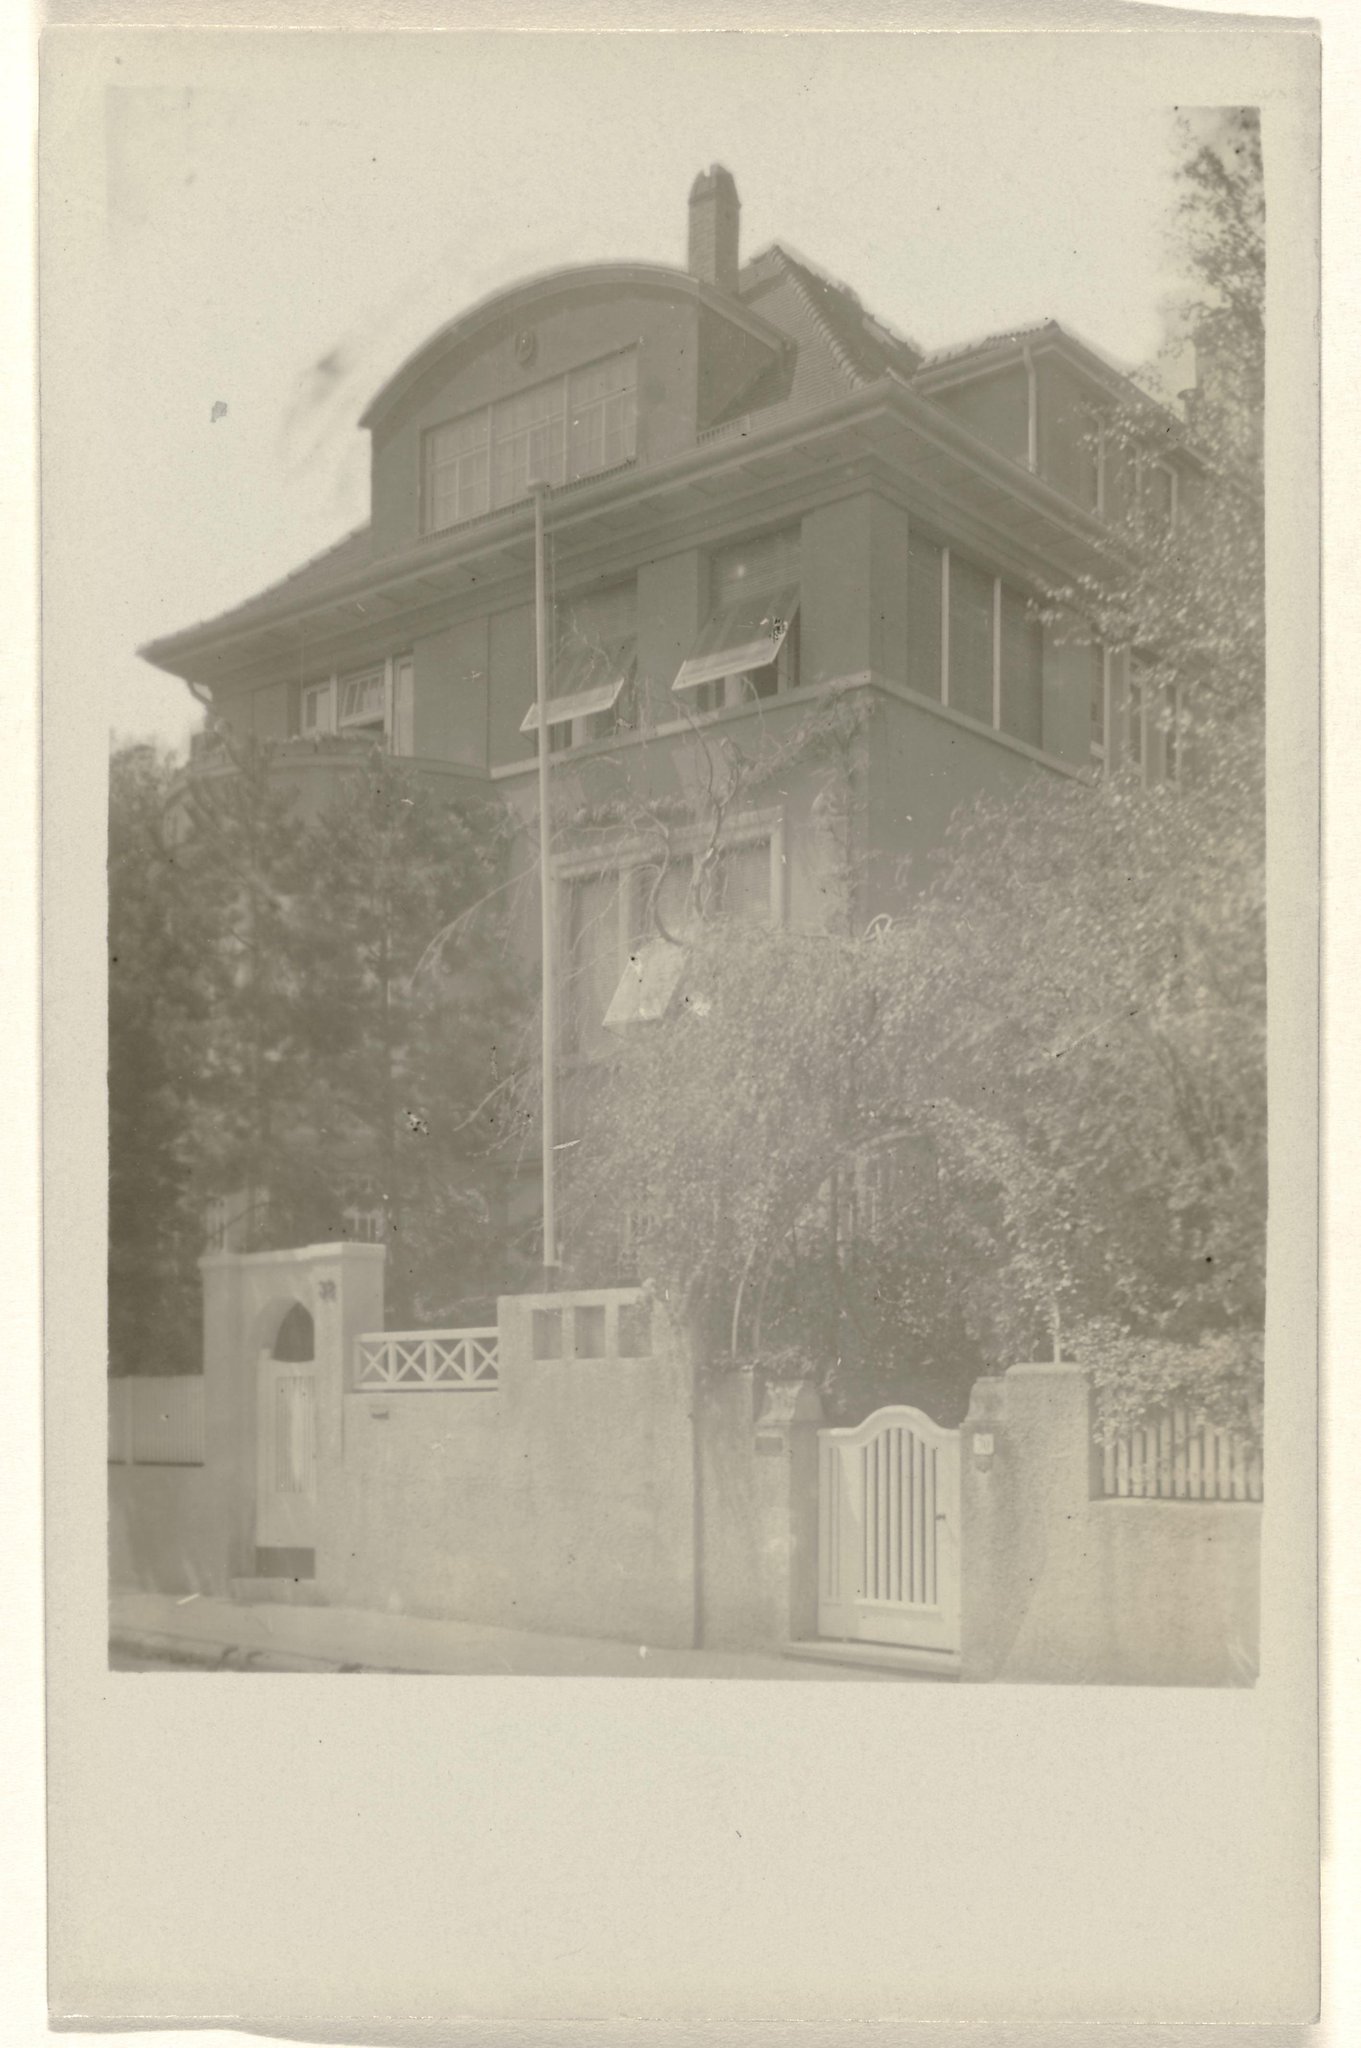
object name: photograph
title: Briefkaart van een groot gebouw met openstaande ramen aan de linkerzijde van het gebouw, en een hek en begroeiing op de voorgrond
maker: Anonymous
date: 1900-1950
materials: photographic support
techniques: gelatin silver print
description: Briefkaart van een groot gebouw met openstaande ramen aan de linkerzijde van het gebouw, en een hek en begroeiing op de voorgrond